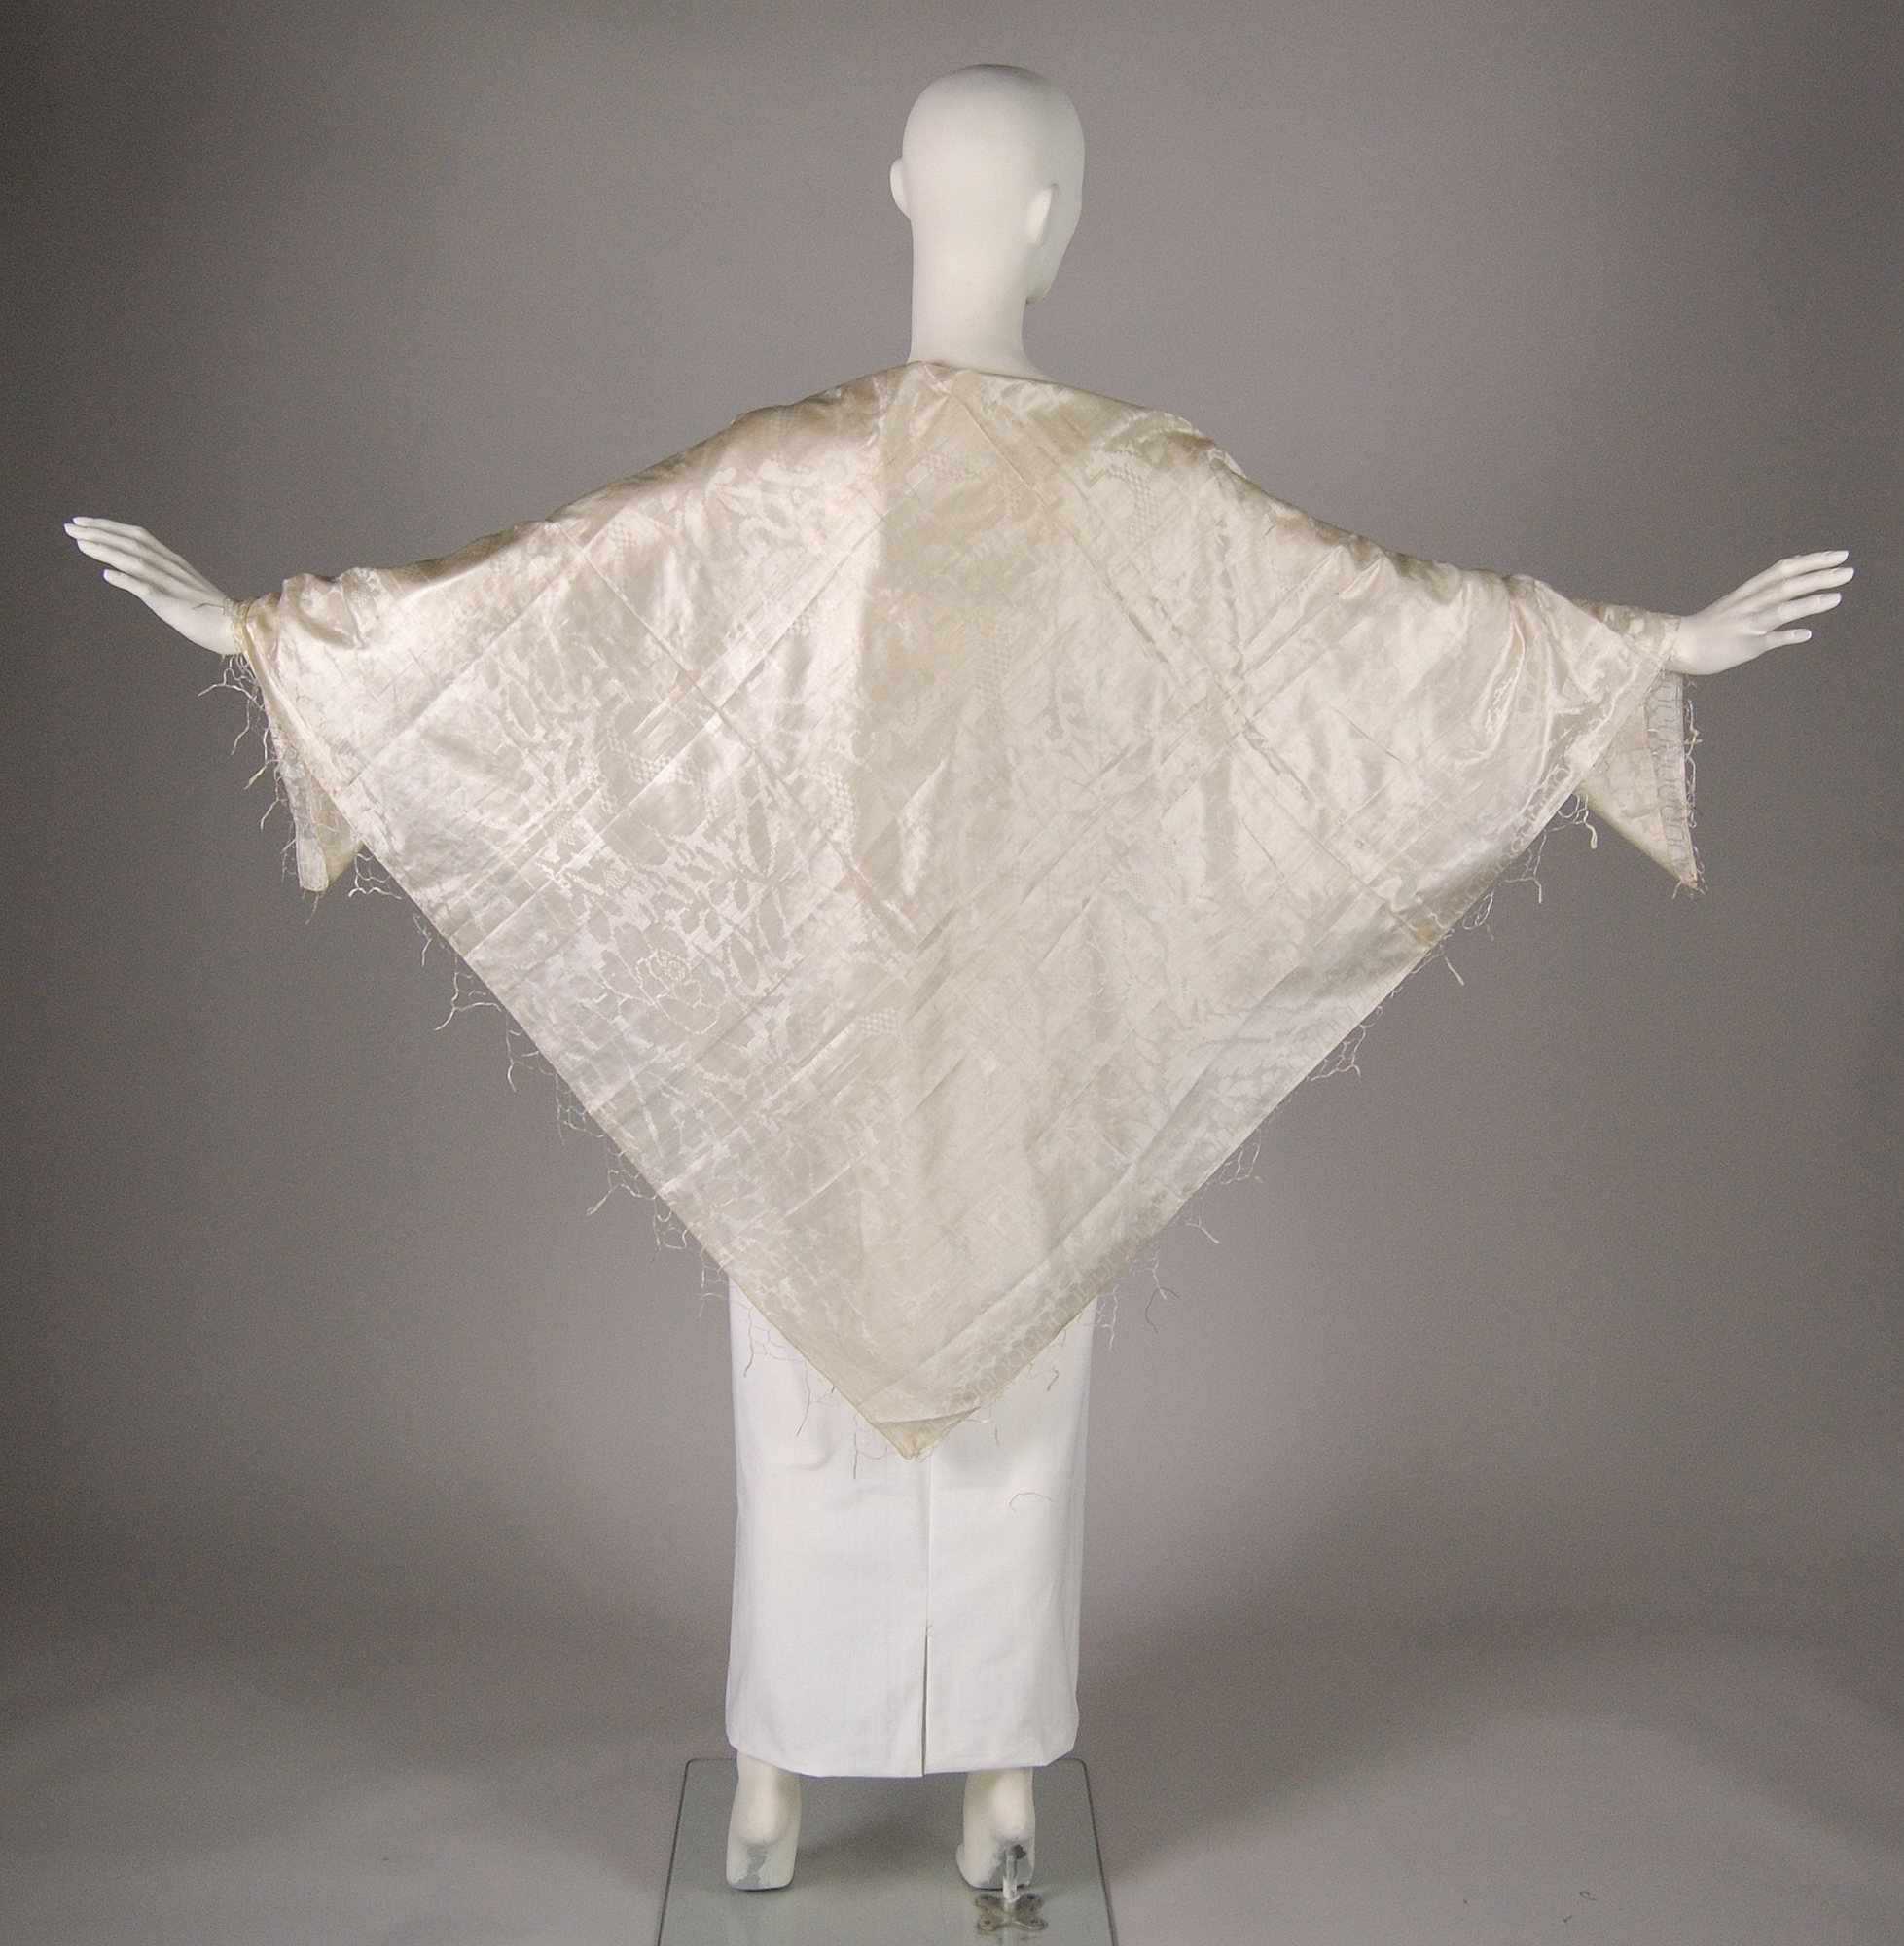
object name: shawl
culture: chinese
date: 1840-1860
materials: silk